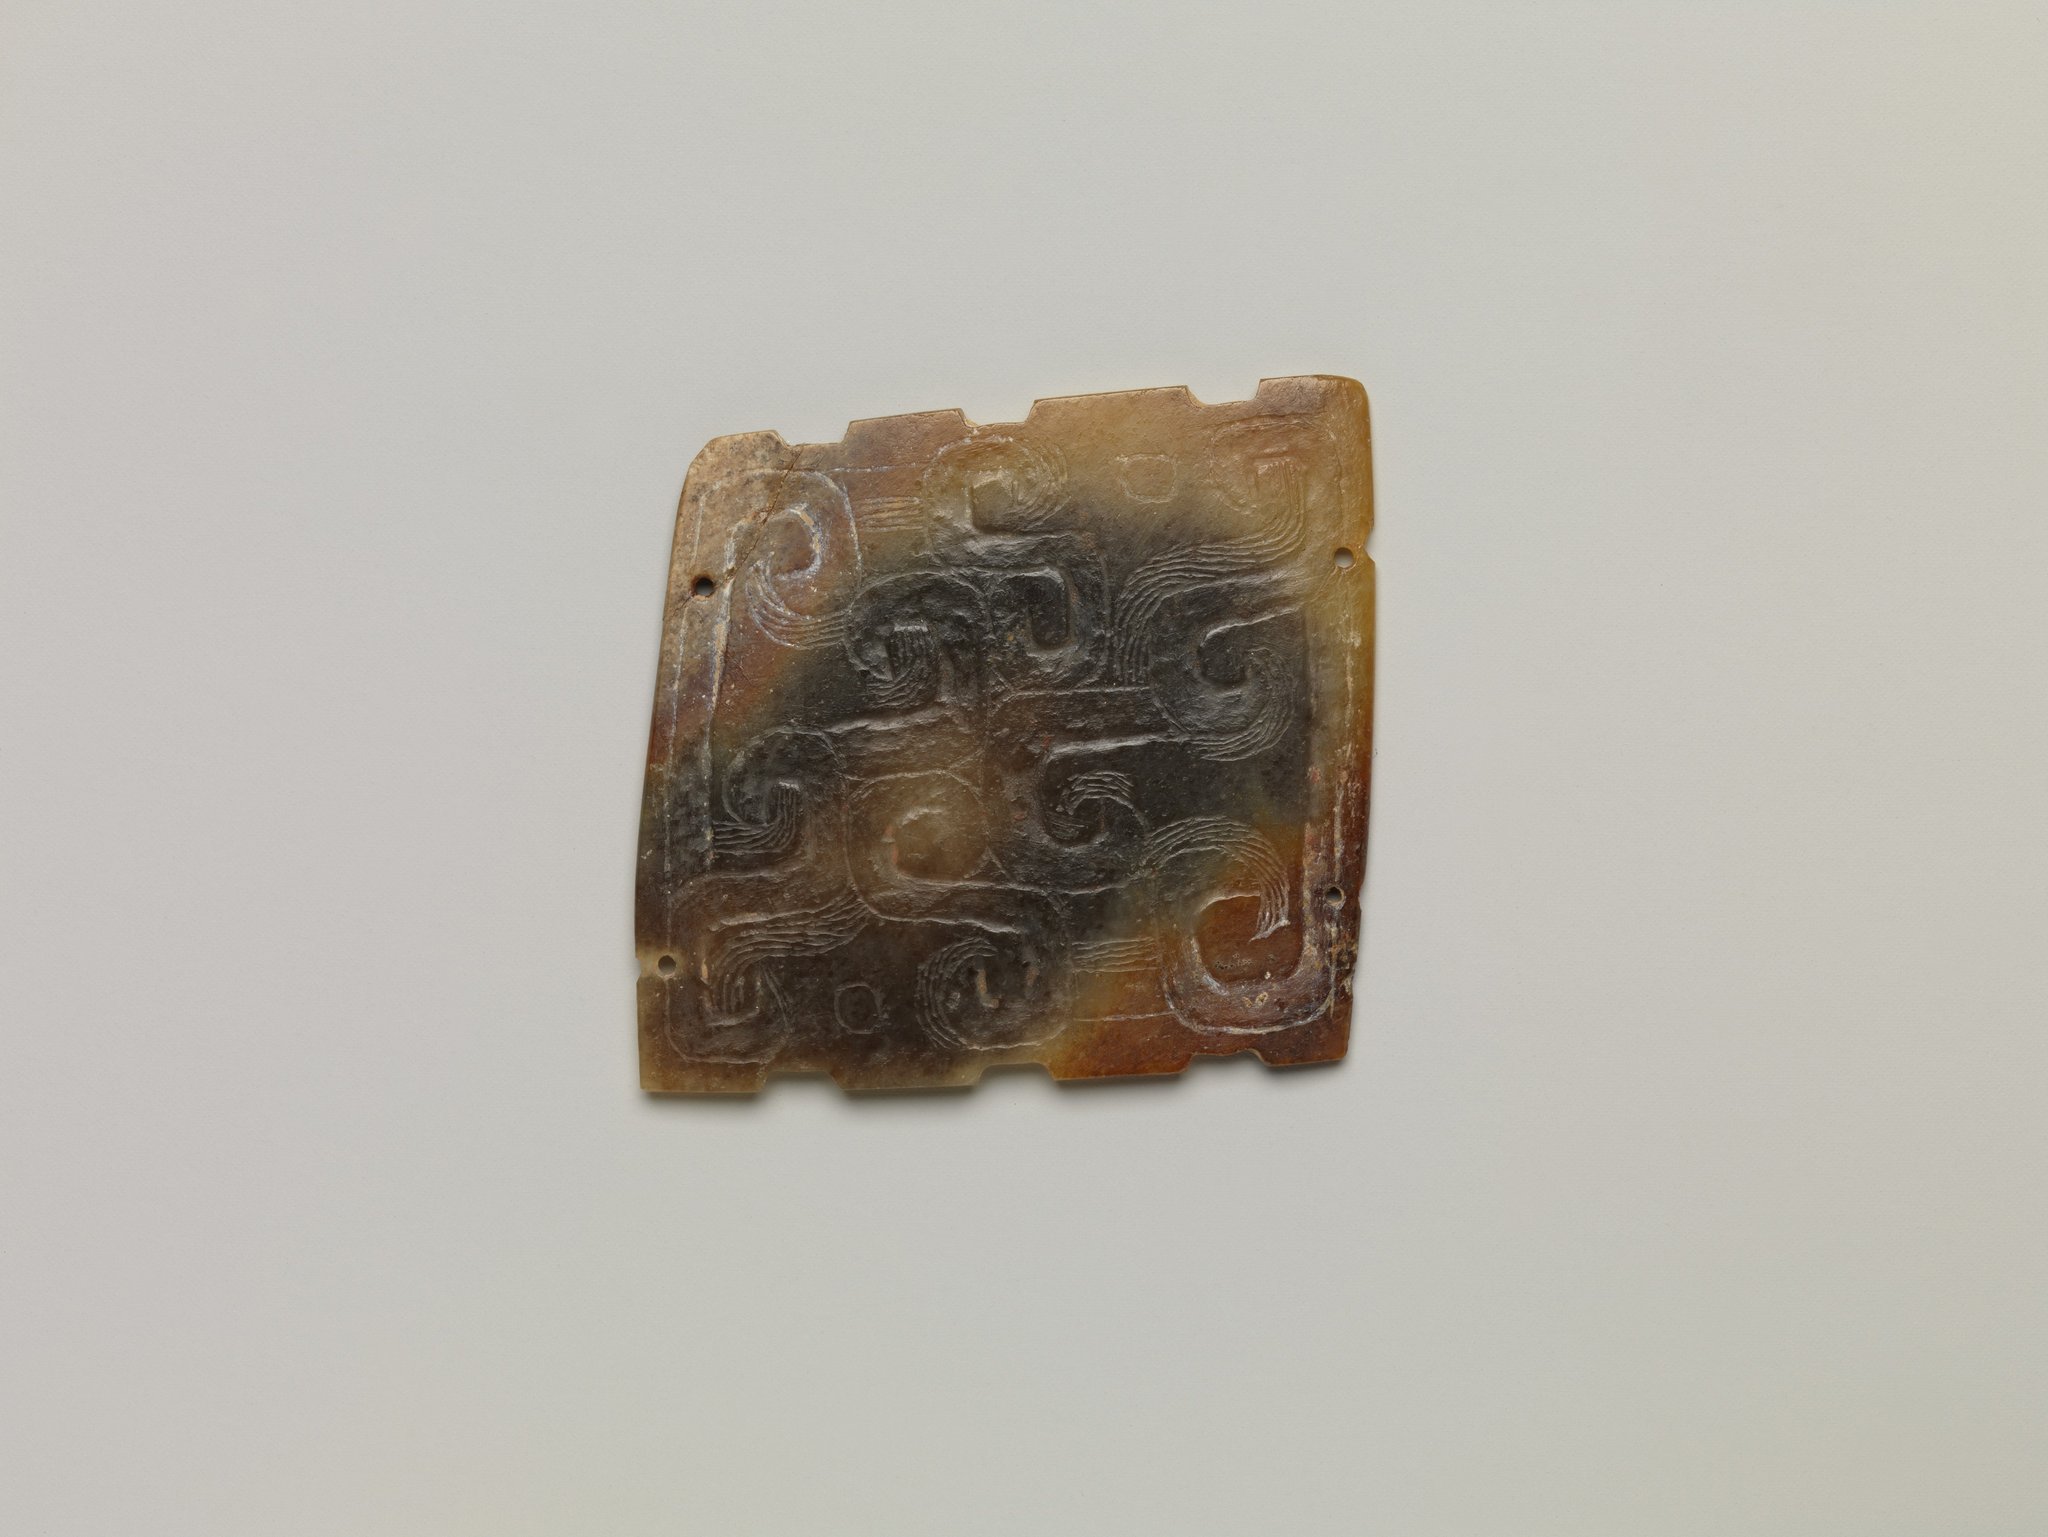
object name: plaque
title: Plaque with incised designs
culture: chinese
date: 500-401 BCE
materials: jade